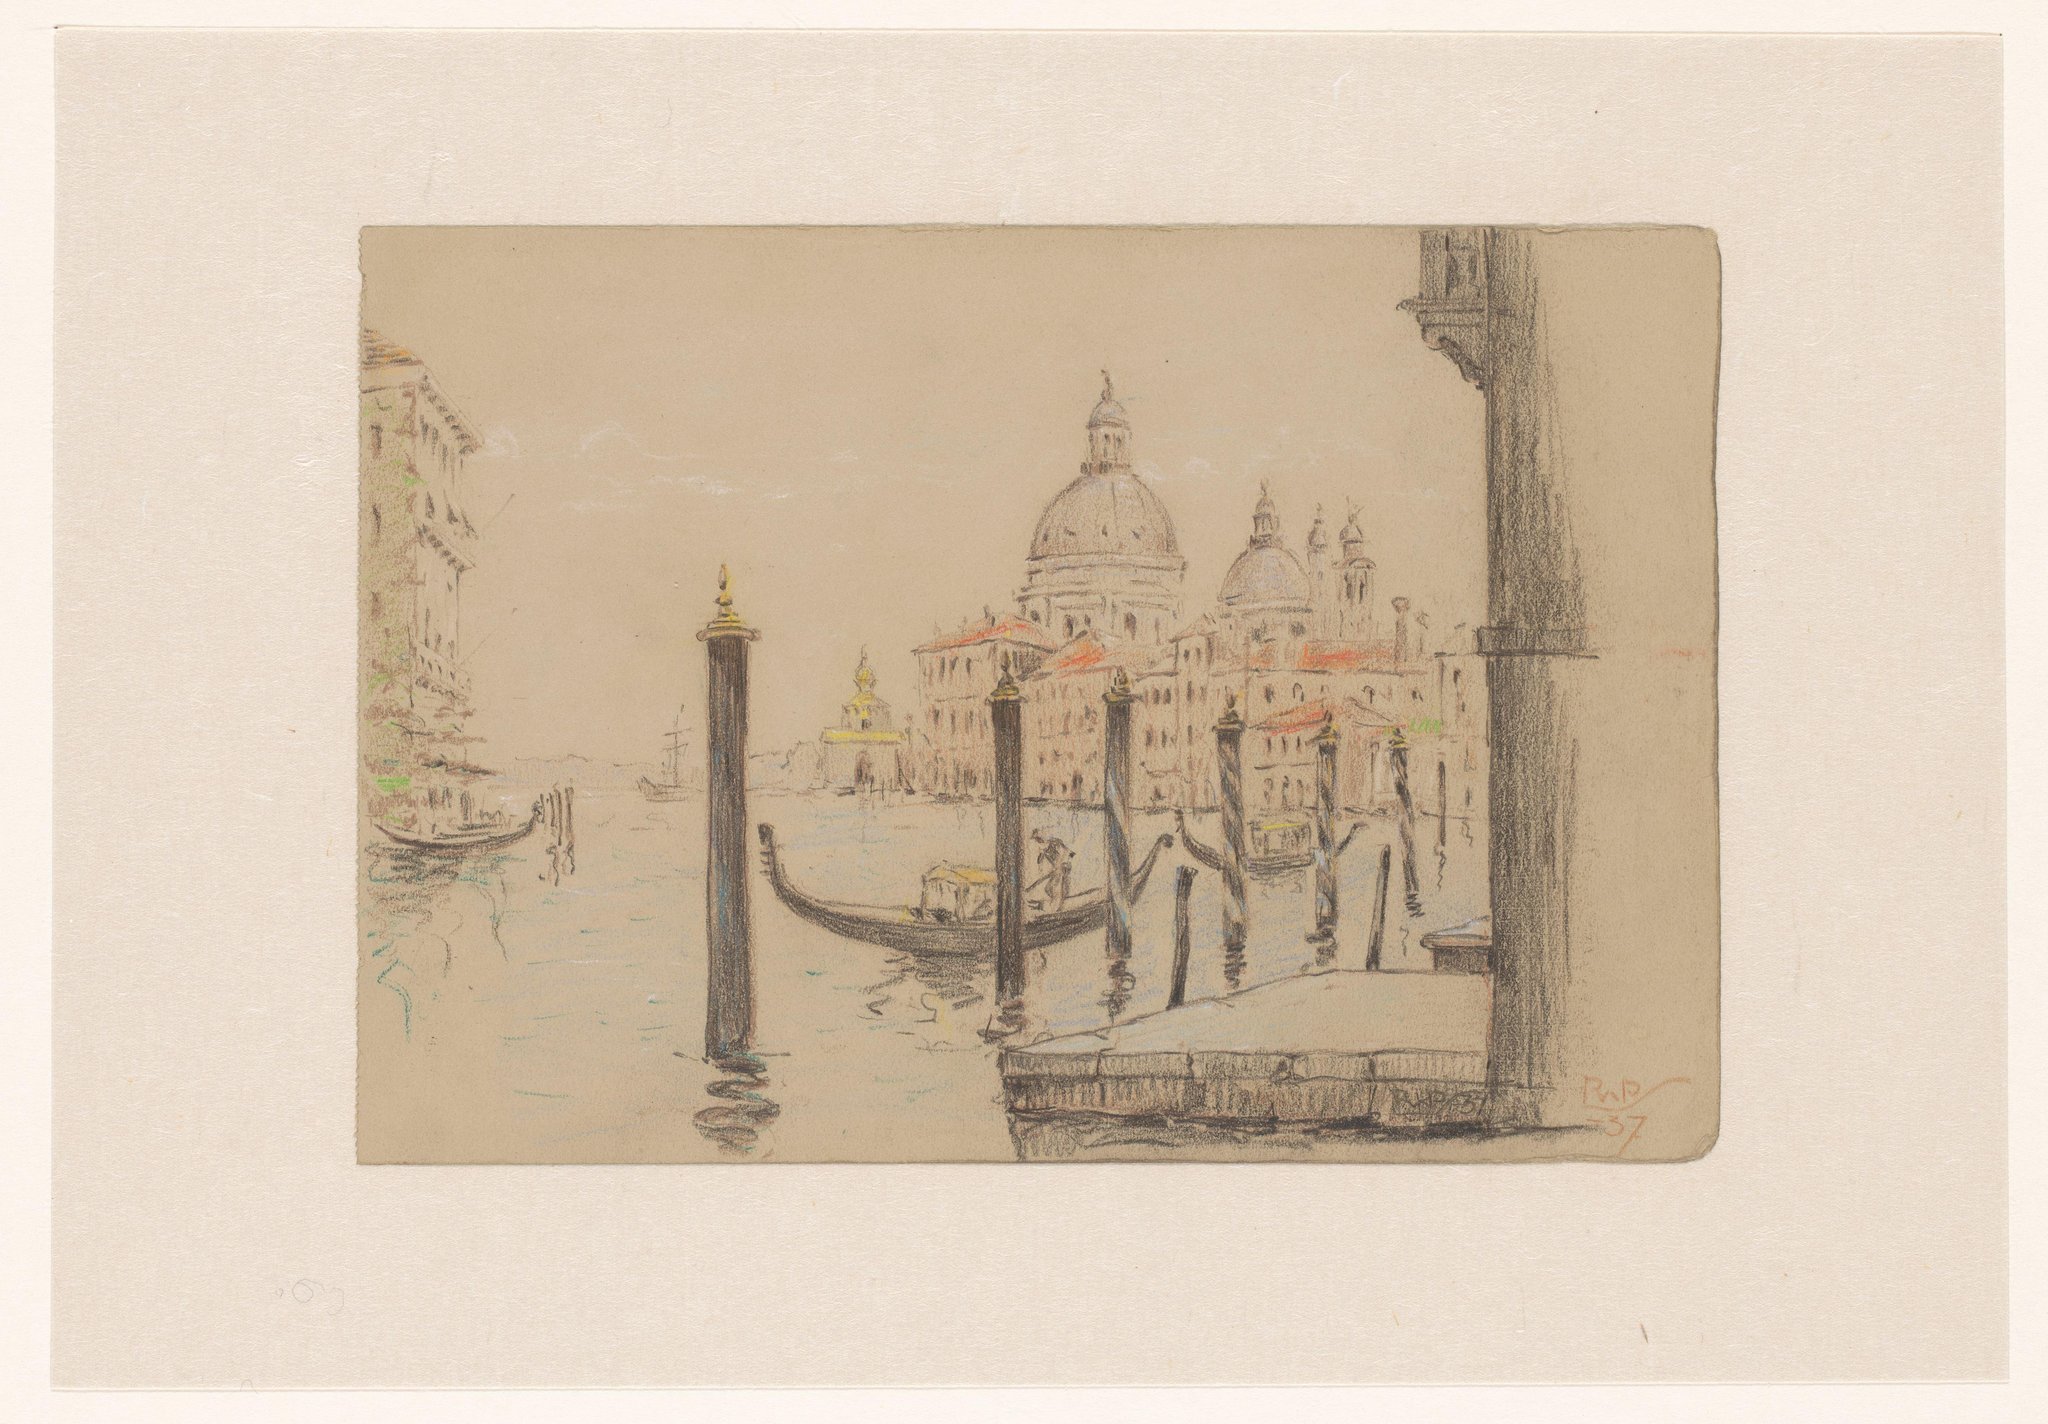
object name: drawing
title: Gezicht op het Canal Grande te Venetië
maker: reinier willem petrus de vries (1874-1953)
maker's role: draughtsman, print maker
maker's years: 1874-1953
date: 1937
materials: chalk, paper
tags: canals, waters (in city), gondola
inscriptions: collector's mark: ‘R:MVS.’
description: In de achtergrond de Basiliek van Santa Maria della Salute.